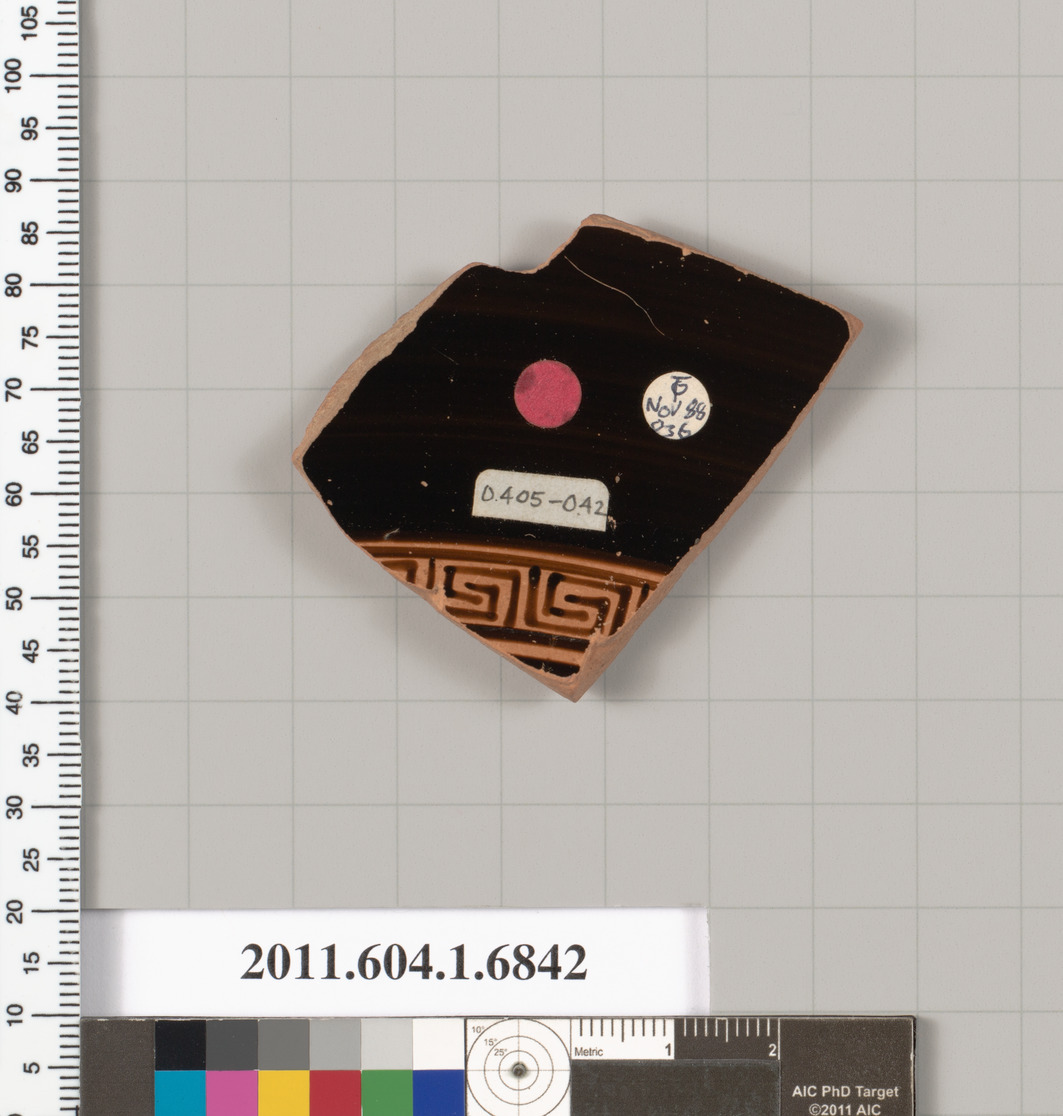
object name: kylix fragment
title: Terracotta fragment of a kylix (drinking cup)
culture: greek, attic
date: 490-470 BCE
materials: terracotta